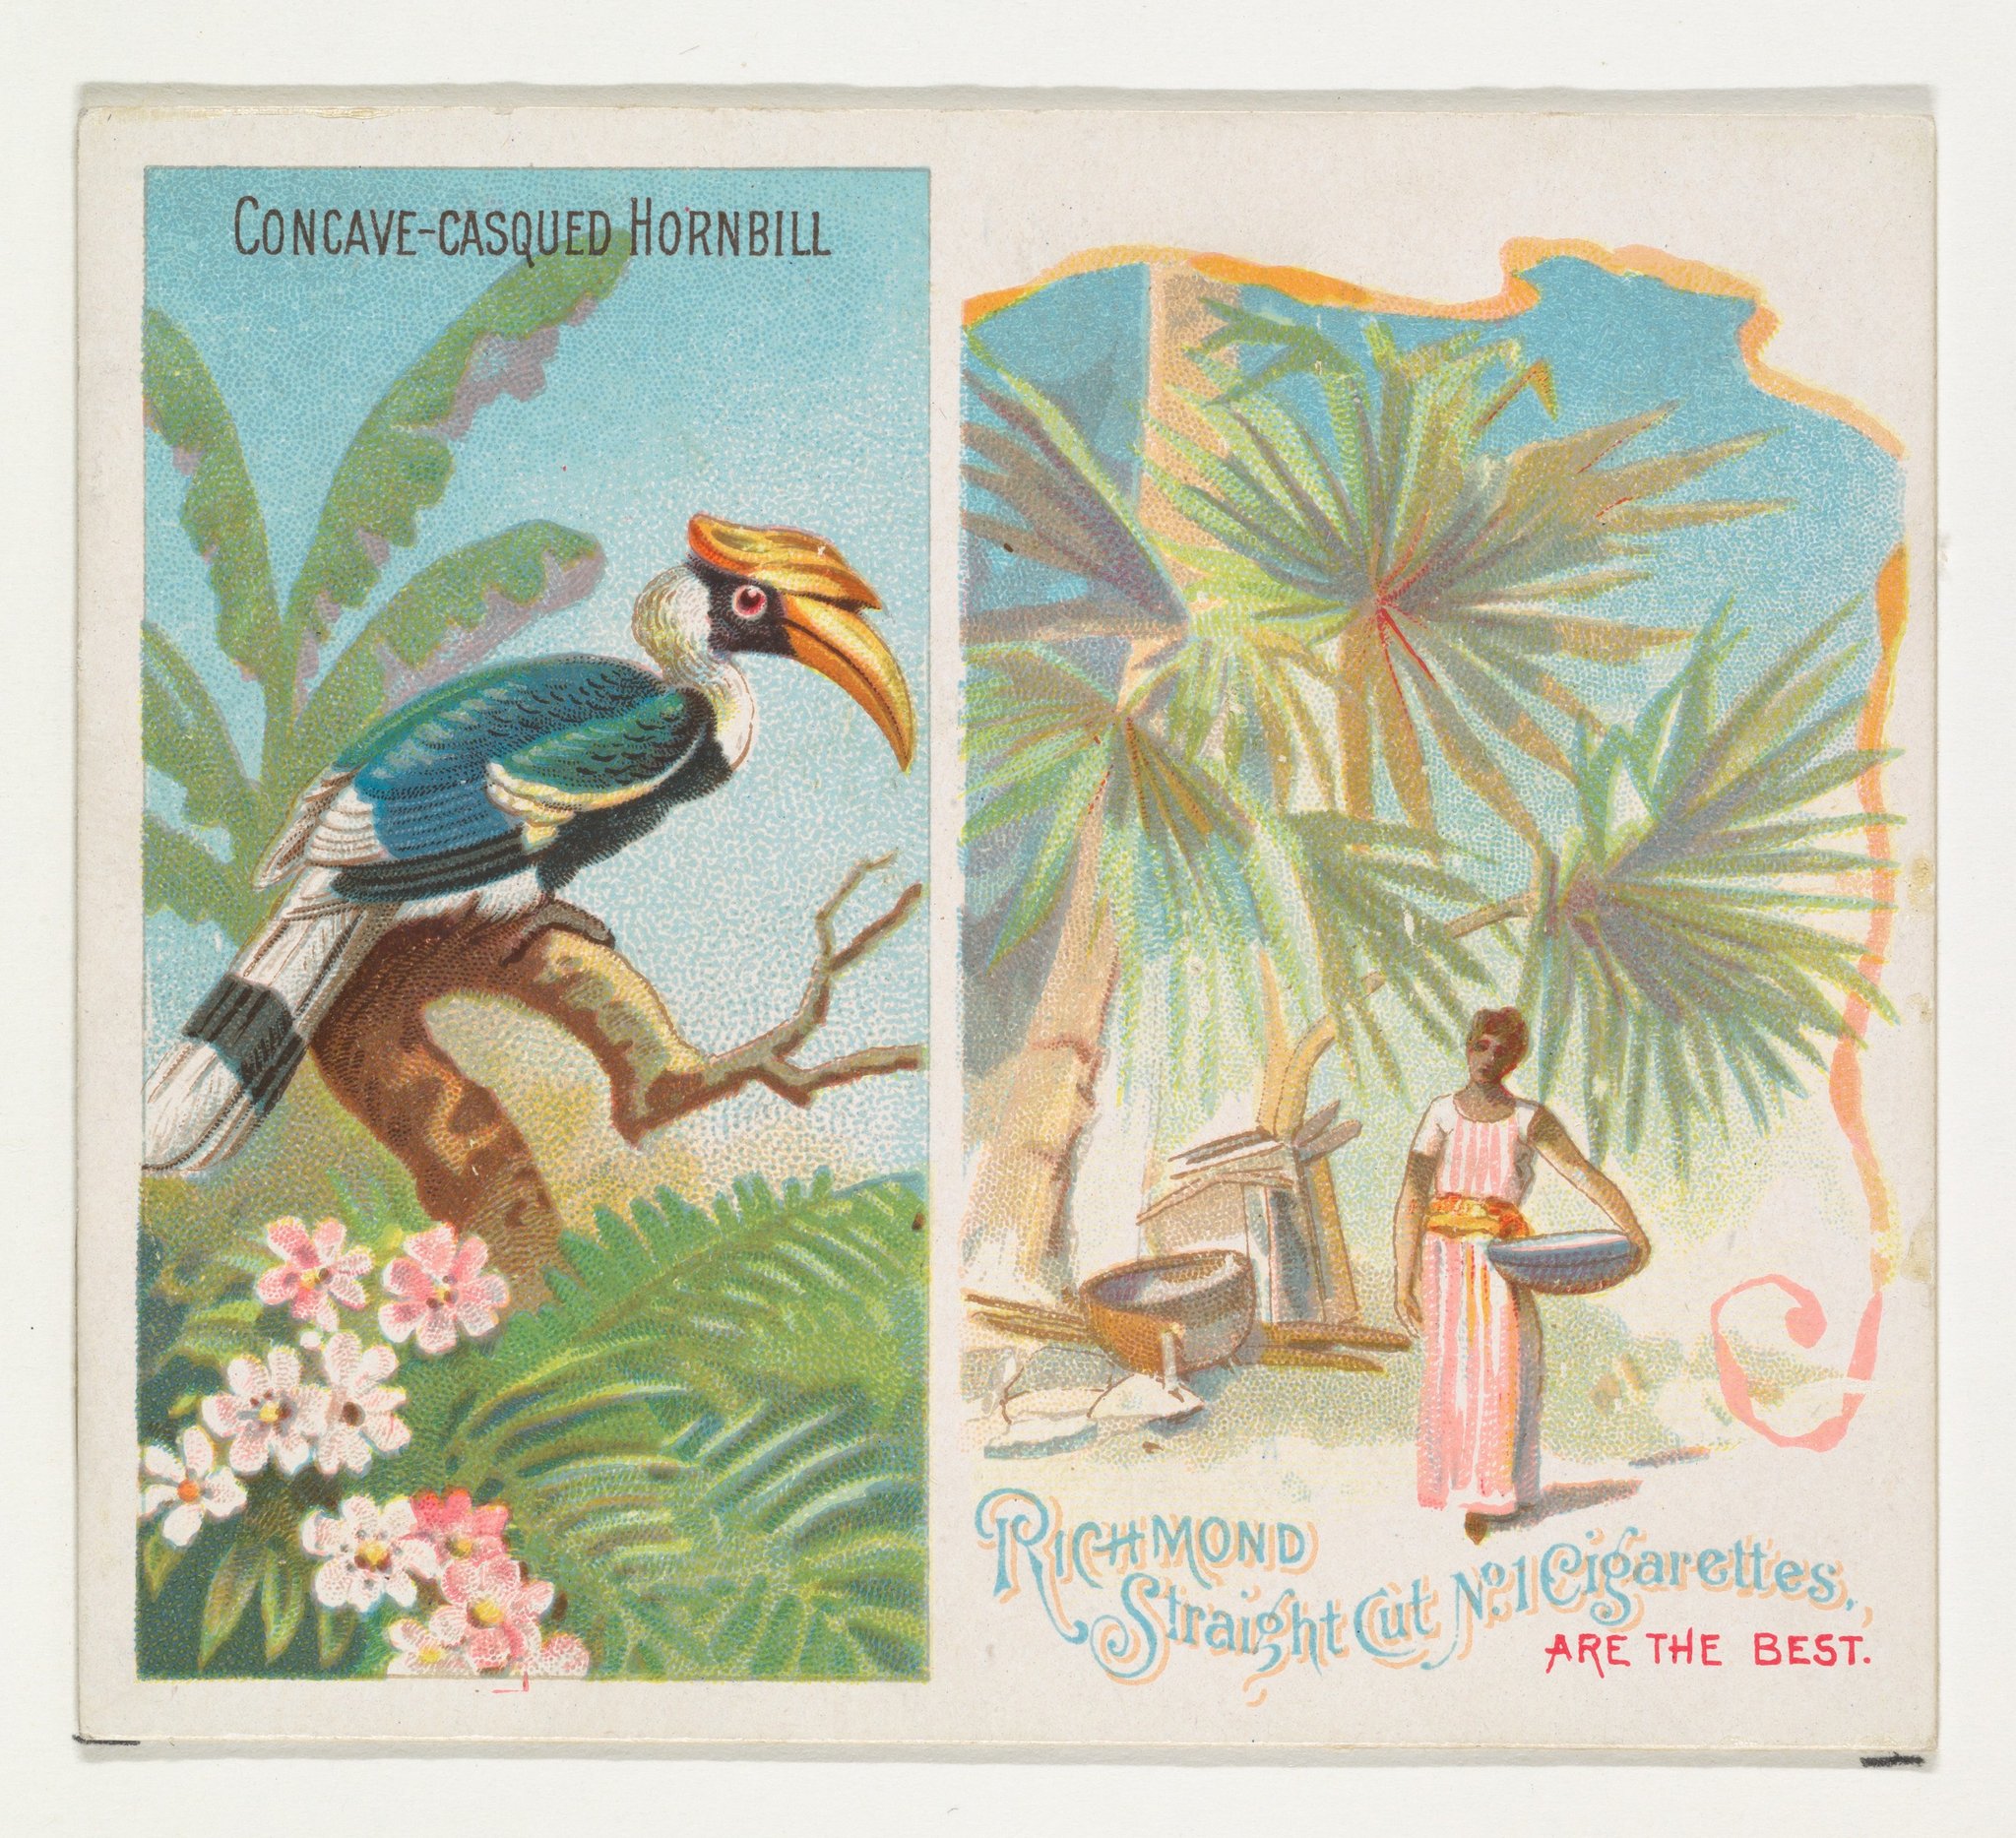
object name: print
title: Concave-Casqued Hornbill, from Birds of the Tropics series (N38) for Allen & Ginter Cigarettes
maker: allen & ginter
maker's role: publisher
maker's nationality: american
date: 1889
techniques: color lithograph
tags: birds,women